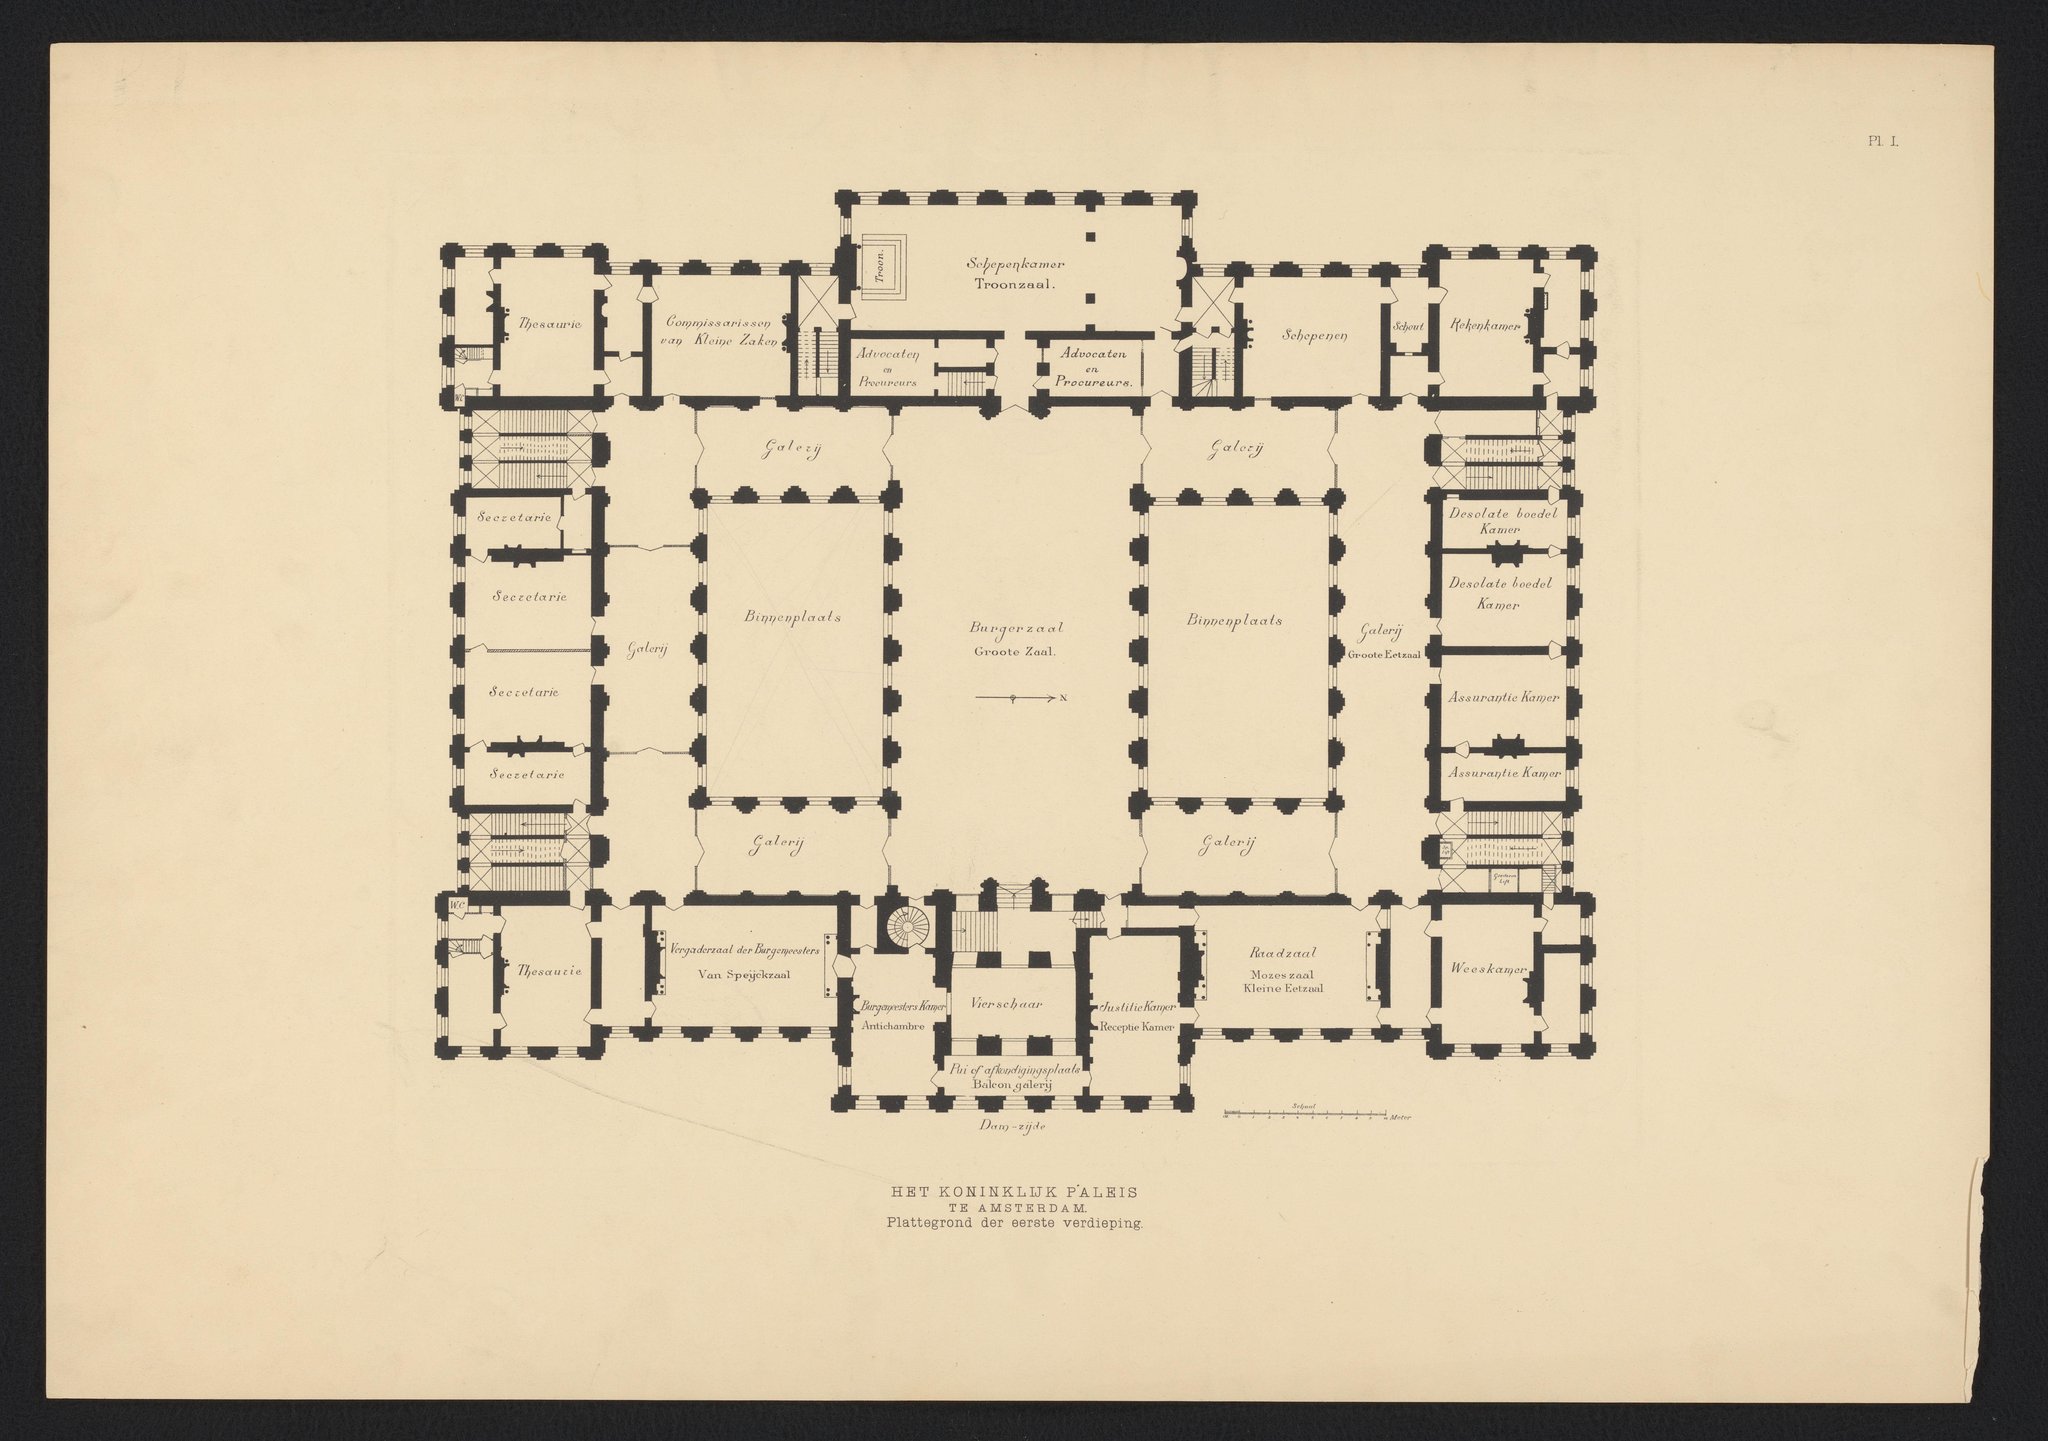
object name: photograph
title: Het Koninklijk Paleis te Amsterdam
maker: Anonymous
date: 1899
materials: cardboard, paper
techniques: photograph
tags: palace, plan ~ architecture, royal palace of amsterdam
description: Het Koninklijk Paleis te Amsterdam. Plattegrond der eerste verdieping.